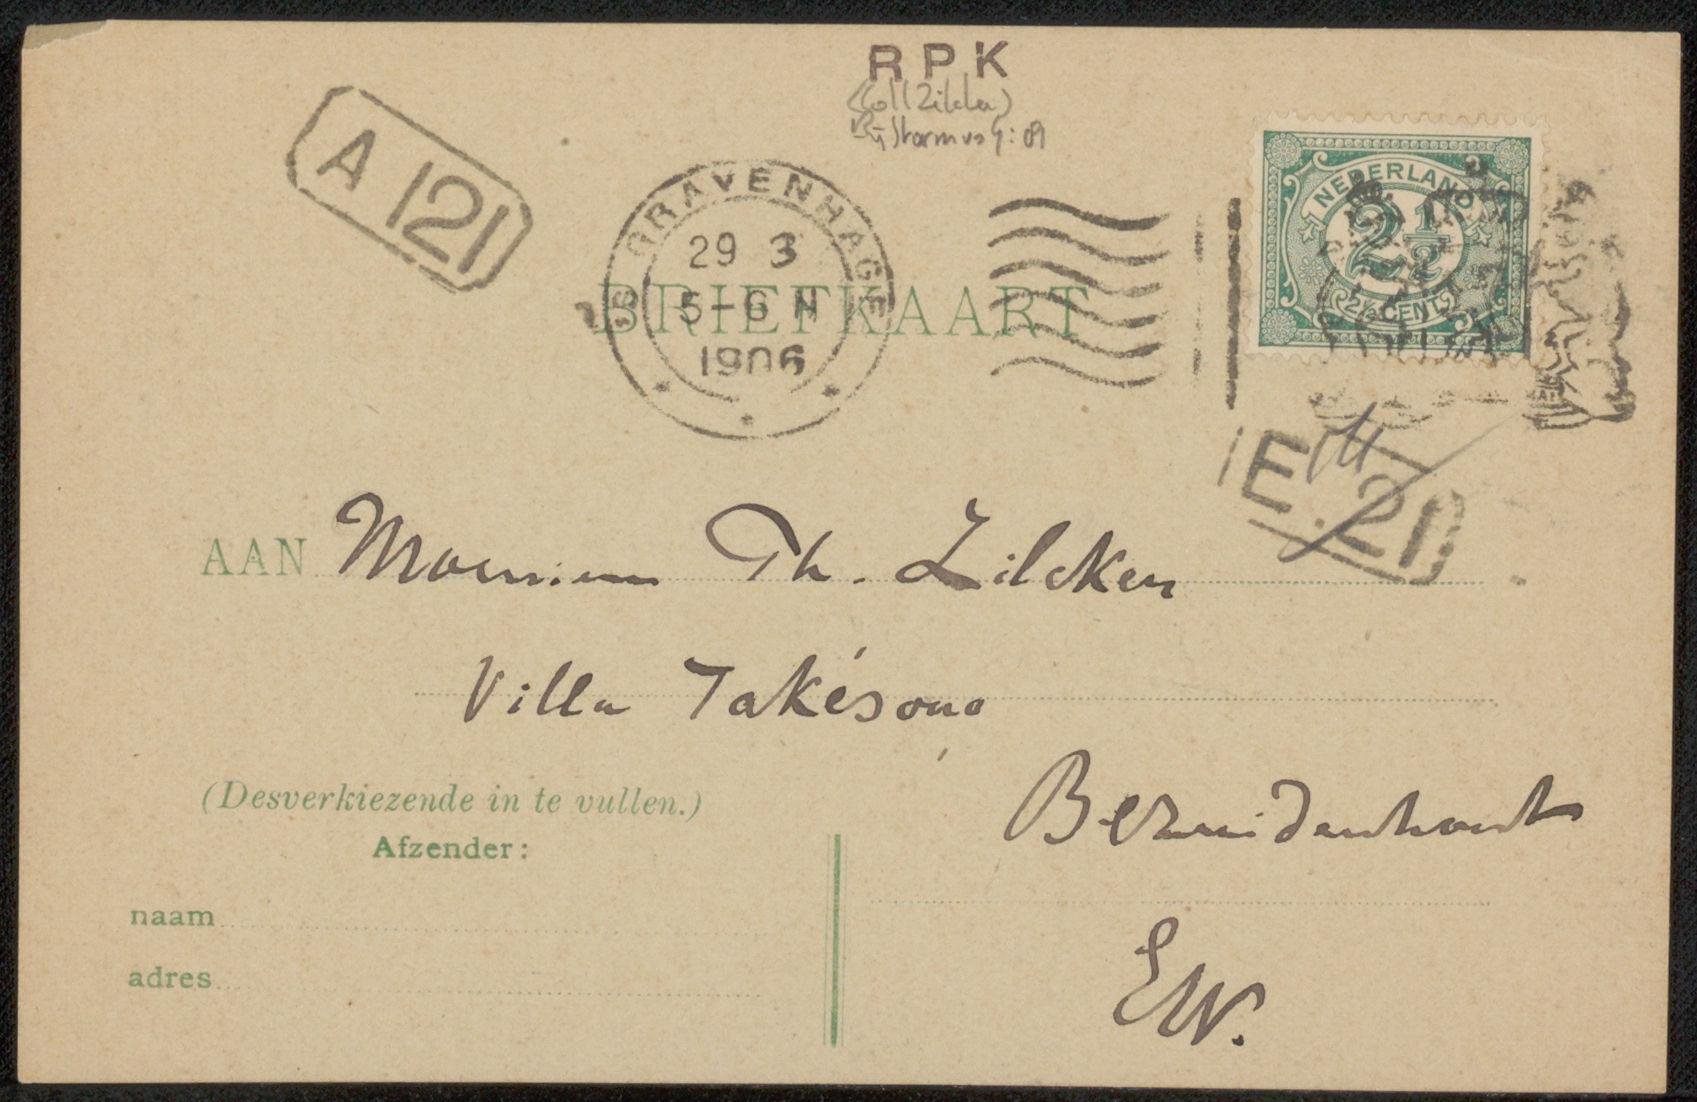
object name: letter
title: Brief aan Philip Zilcken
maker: carel nicolaas storm van s-gravesande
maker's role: draughtsman, print maker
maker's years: 1841-1924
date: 1906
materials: cardboard, ink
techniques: pen, writing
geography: the hague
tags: painter, philip zilcken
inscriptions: collector's mark: ‘RPK’